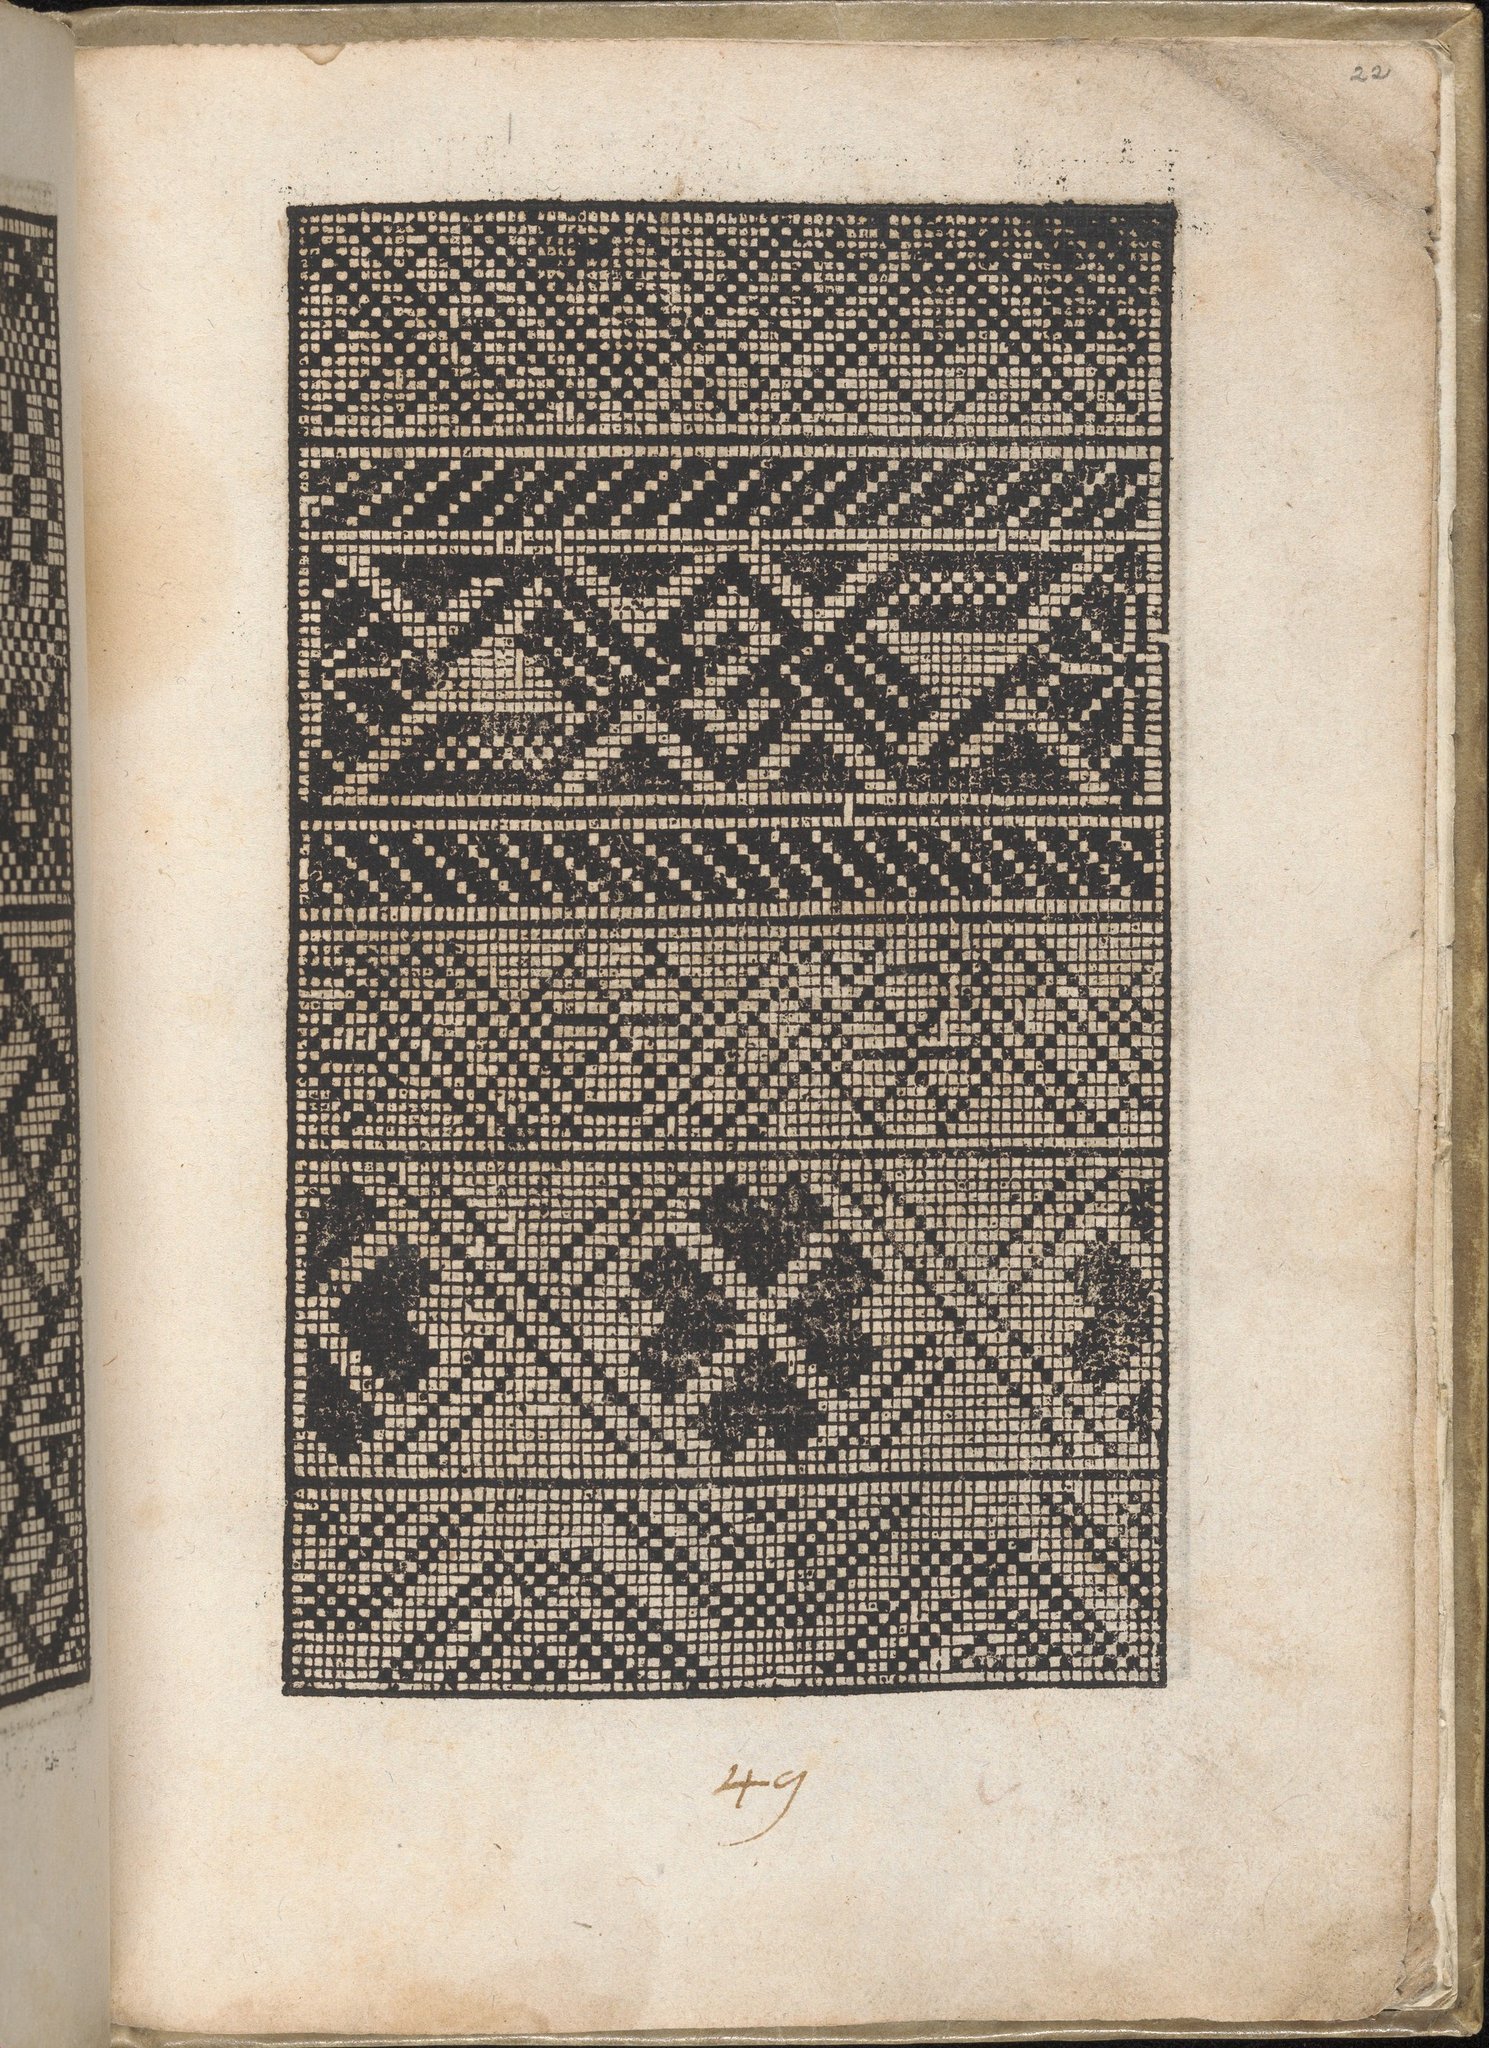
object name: book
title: Page 23r, from "Eyn New Kunstlichboich"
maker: peter quentel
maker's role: publisher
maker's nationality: german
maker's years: 1500-1550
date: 1529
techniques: woodcut